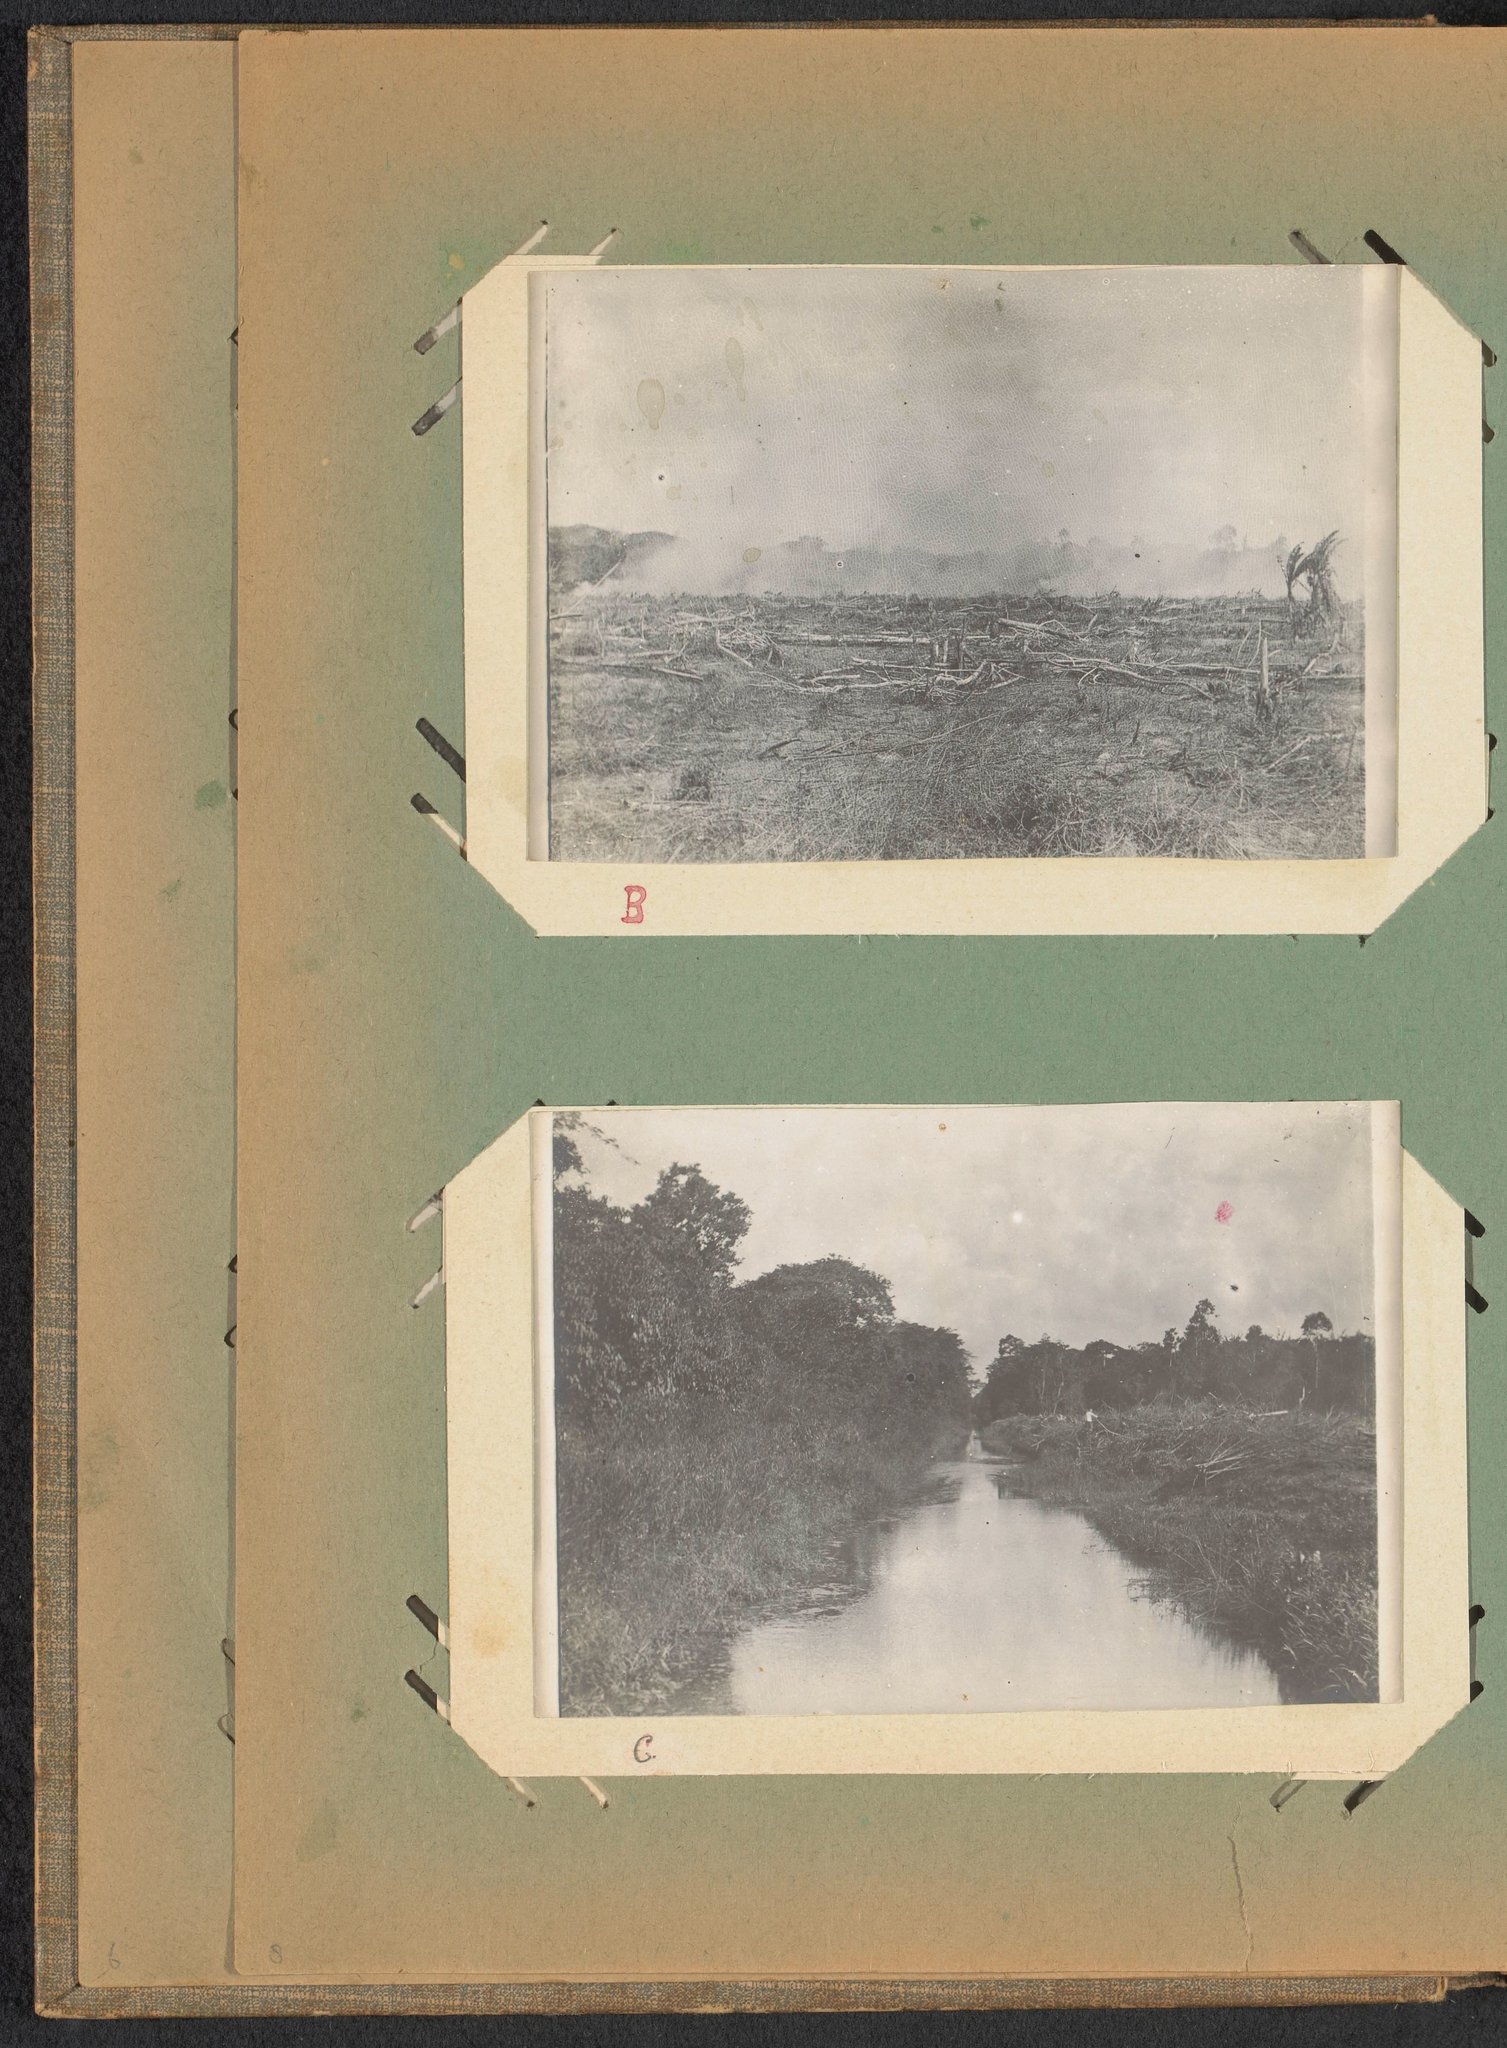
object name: photograph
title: Vaart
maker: Anonymous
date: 1912-1913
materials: paper, photographic support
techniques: gelatin silver print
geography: suriname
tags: plantation, suriname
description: Vaart tussen percelen (foto gemerkt: C). Waarschijnlijk bij Plantage Peperpot in Suriname. Onderdeel van het fotoalbum uit ca. 1912-1913 met 92 foto's van de plantages Peperpot en Dordrecht in Suriname en Mount Pleasant op Curaçao.